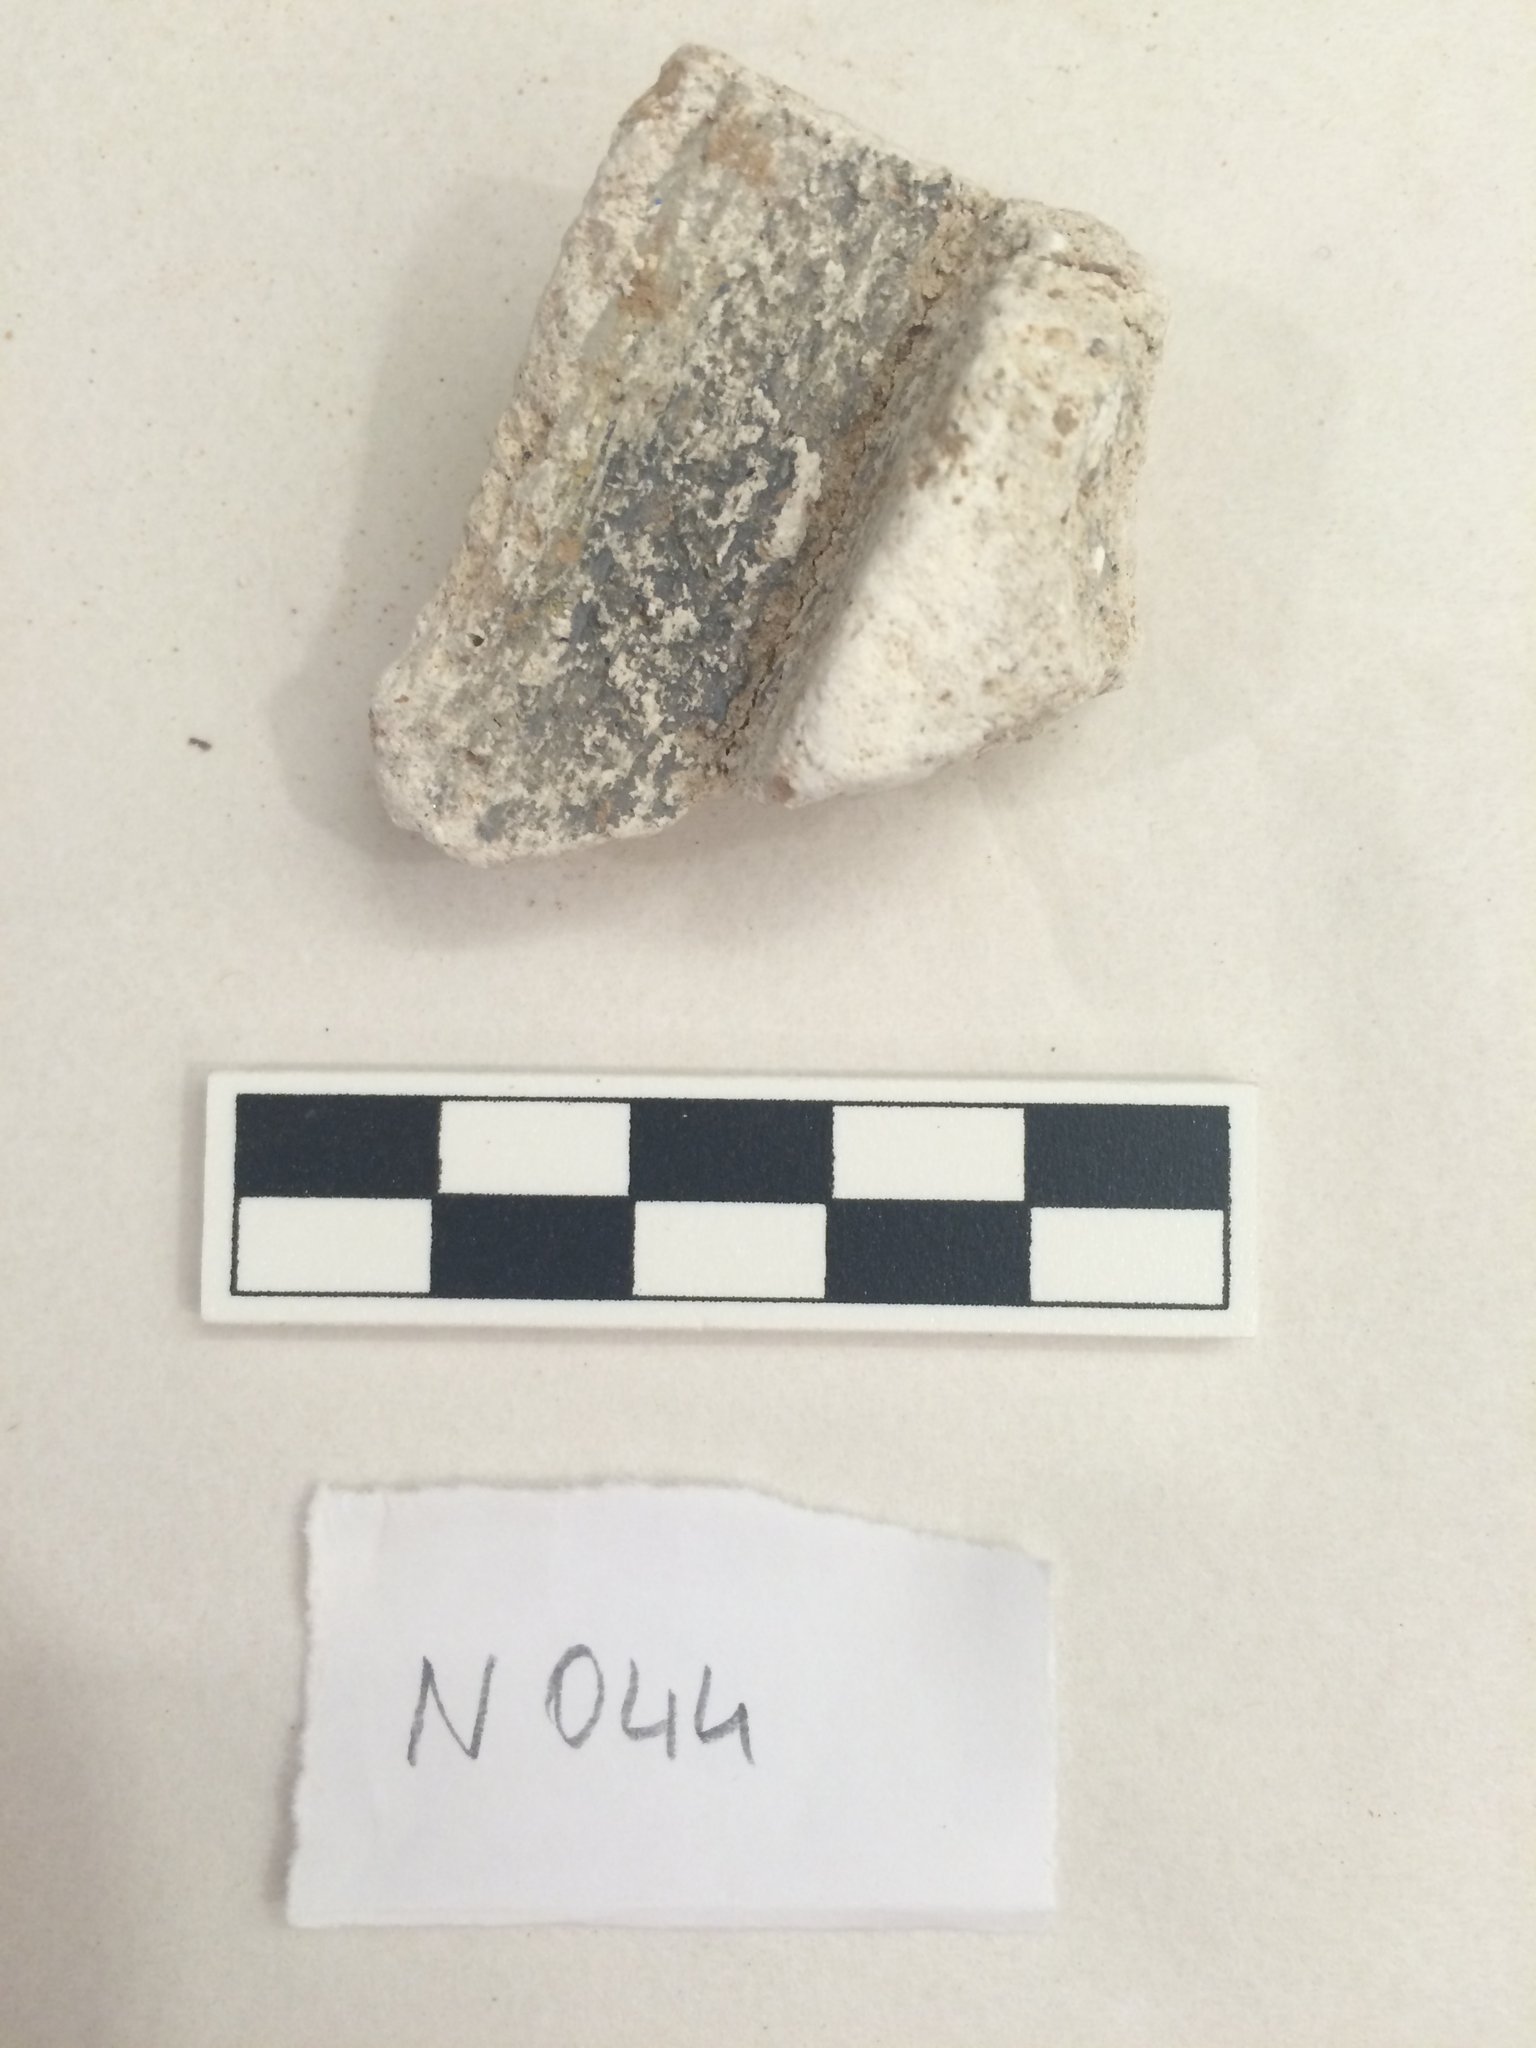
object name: fragment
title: Stucco Fragment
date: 701-1200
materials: plaster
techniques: carving, painting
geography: iran